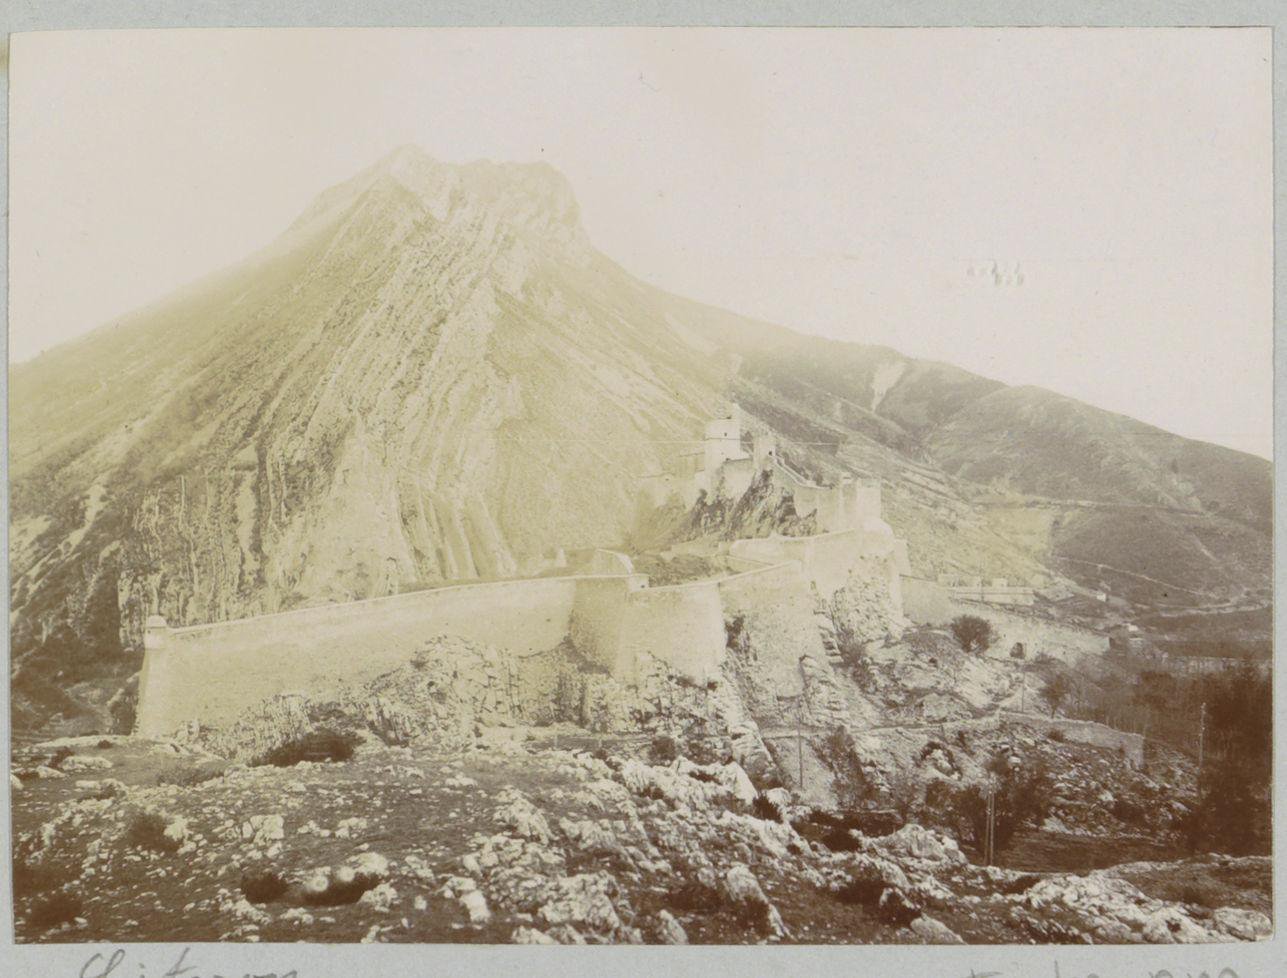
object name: photograph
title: Gezicht op het Fort van Sisteron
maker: delizy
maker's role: manufacturer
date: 1903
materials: paper, photographic support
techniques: gelatin silver print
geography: sisteron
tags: prospect of village, silhouette of village, fortress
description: Onderdeel van Fotoalbum van een Franse amateurfotograaf met opnames van uitstapjes in Frankrijk, Spanje, België, Luxemburg en Nederland, de eerste automobielen en autoraces.